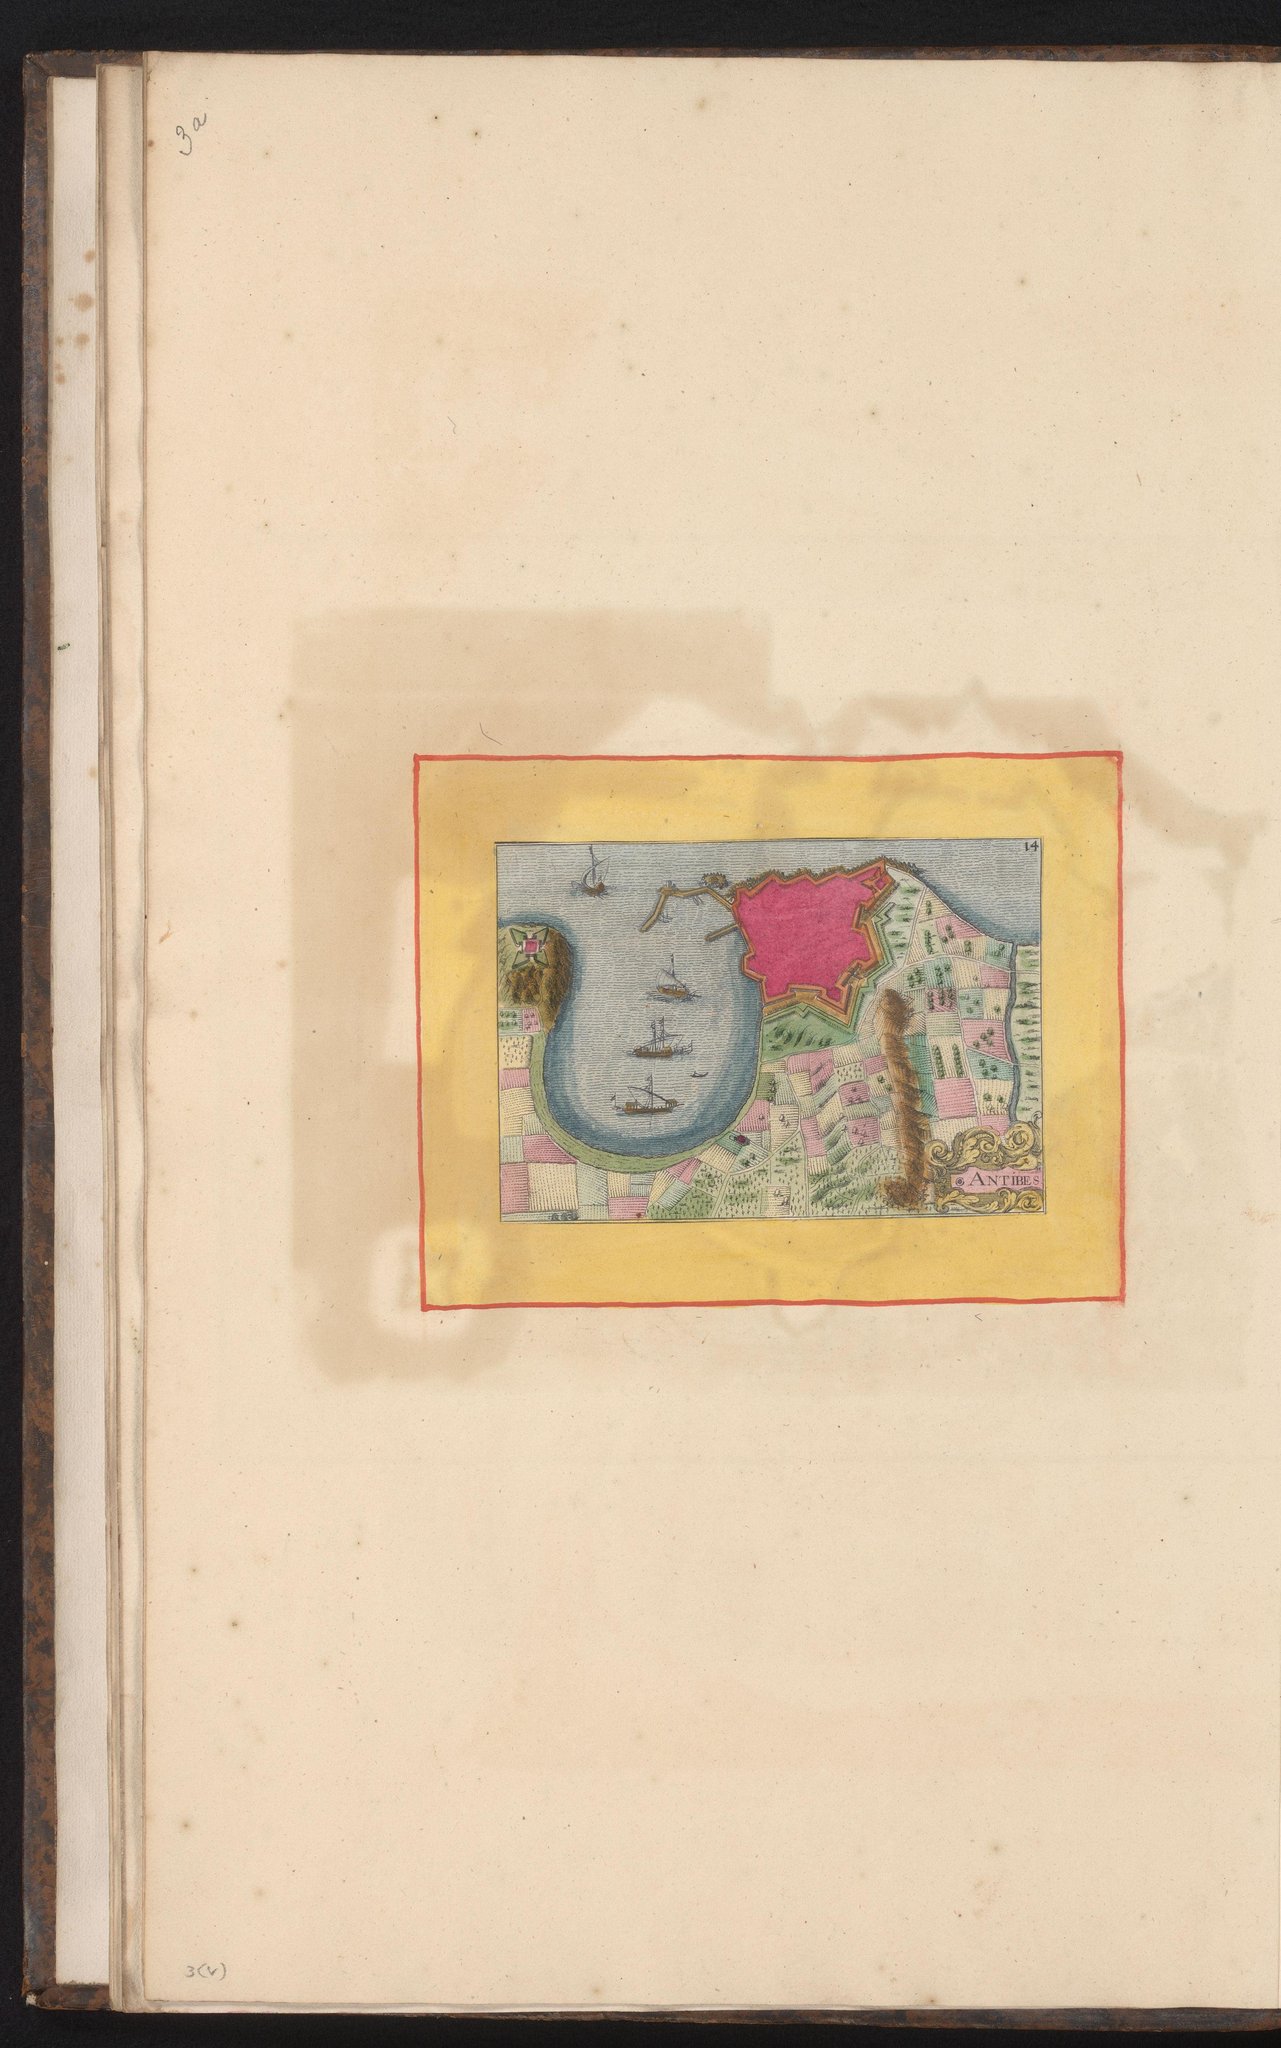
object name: area plan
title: Plattegrond van Antibes en omgeving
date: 1638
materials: paper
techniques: engraving, etching, hand coloring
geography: paris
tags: maps of cities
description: Prent uit: Tassin, Christophe. Les plans et profils de toutes les principales villes et lieux considérables de France (...). Parijs: Michel van Lochom, 1638, prent nummer 14 in het deel 'Provence'.